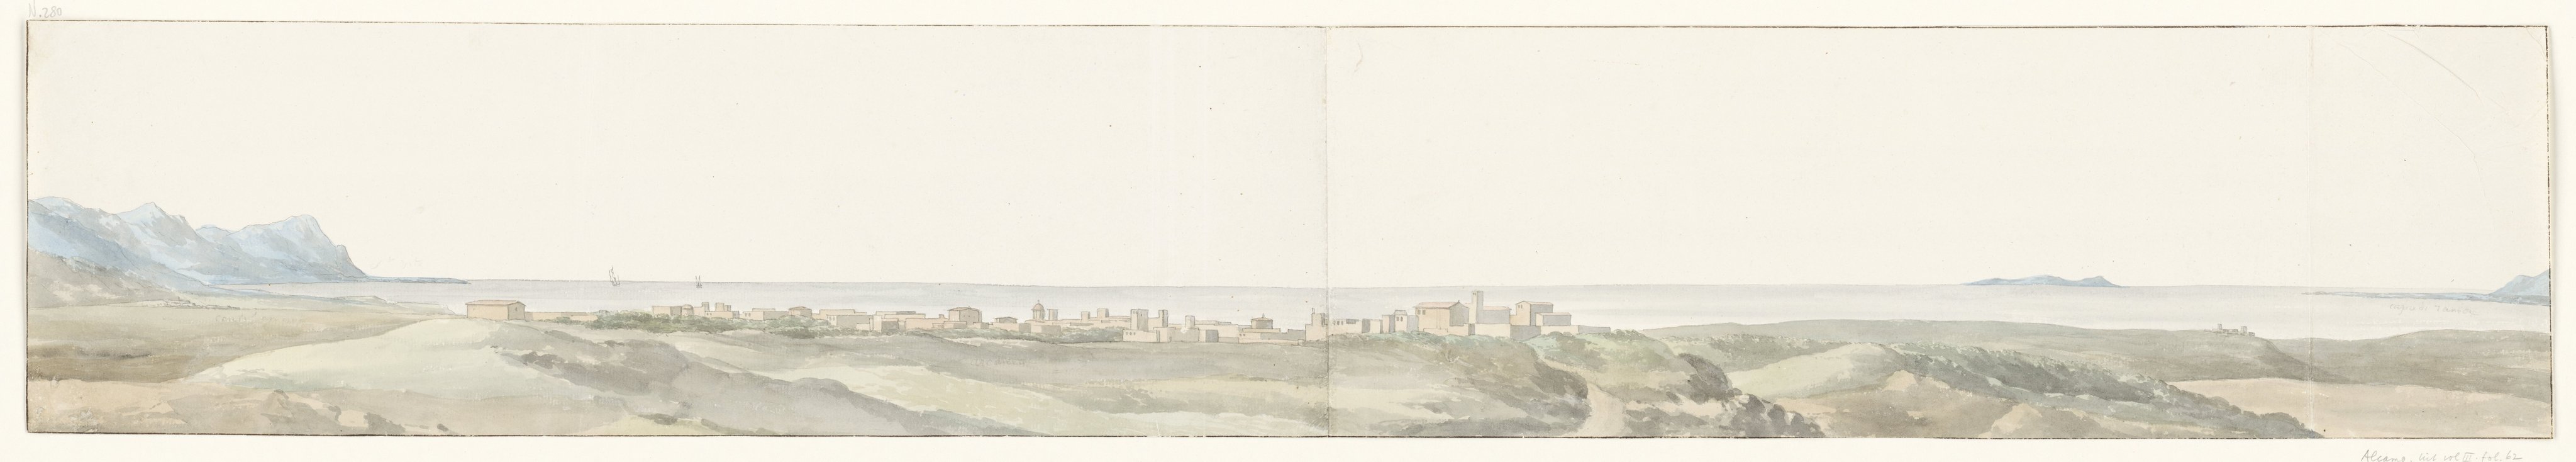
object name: watercolor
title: Vue de la Ville d'Alcamo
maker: louis ducros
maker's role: draughtsman, print maker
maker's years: 1748-1810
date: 1778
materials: chalk, paper, watercolor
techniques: brush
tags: prospect of city, town panorama, silhouette of city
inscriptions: inscription: ‘No 280 Vue de la Ville d'Alcamo’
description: Tekening uit het album 'Voyage en Italie, en Sicile et à Malte', 1778.